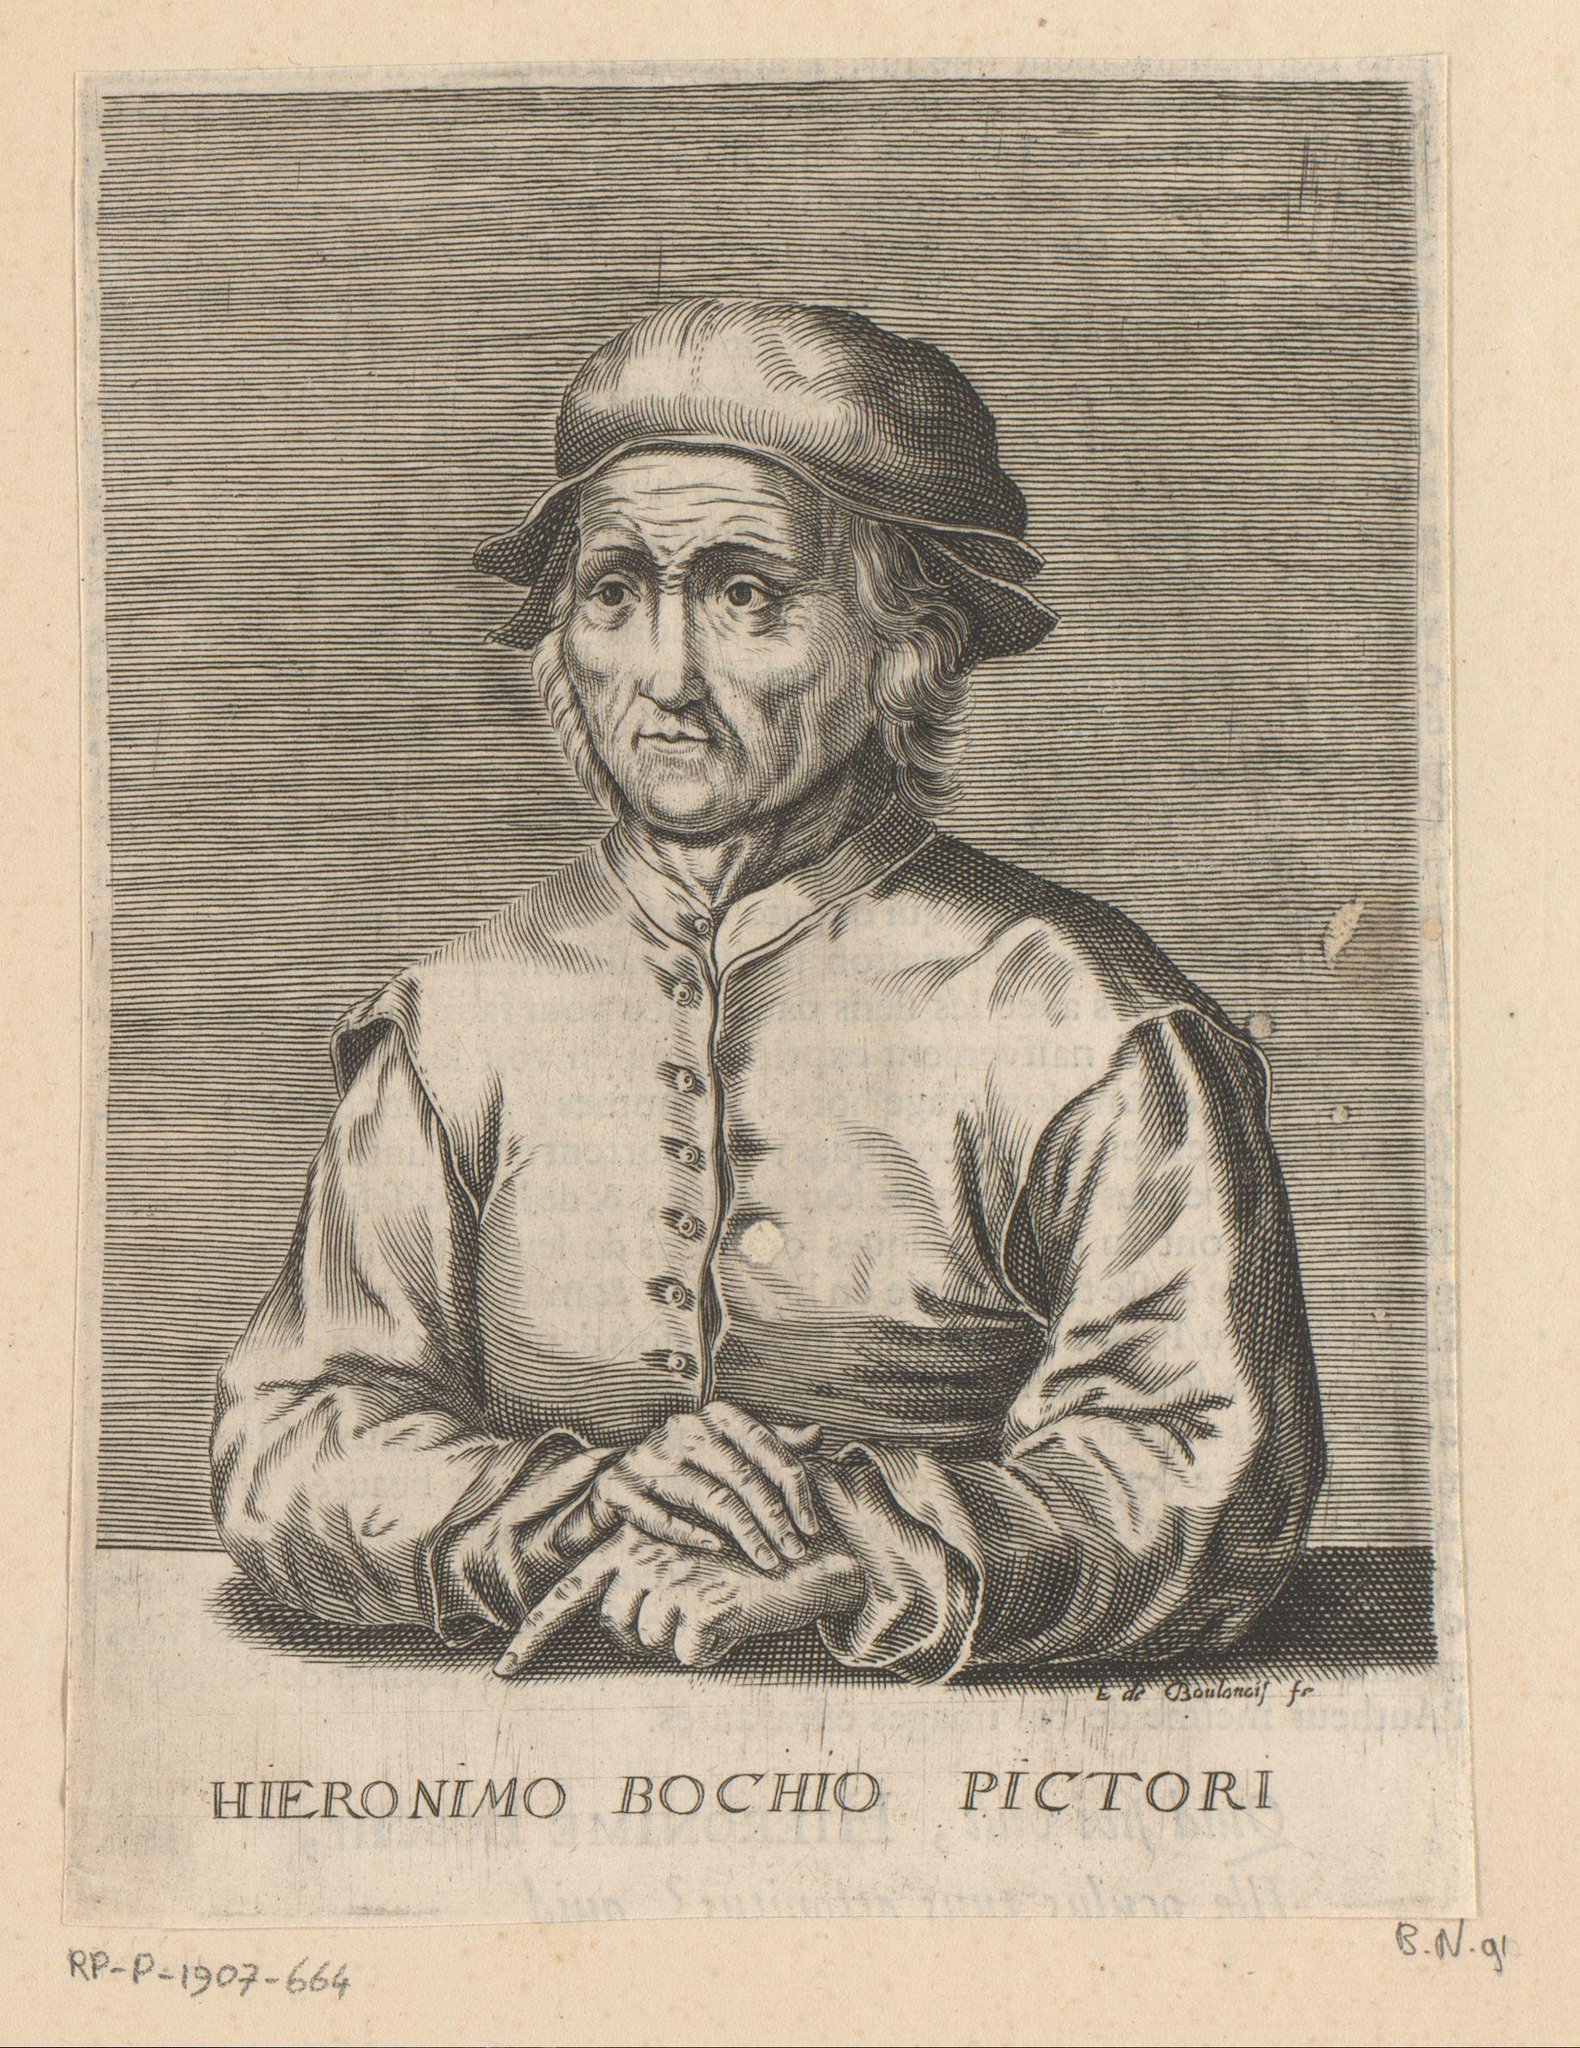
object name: book illustration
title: Portret van Jheronimus Bosch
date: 1682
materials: paper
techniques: engraving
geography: brussels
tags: den bosch, painter, draughtsman, jheronimus bosch, historical persons, portrait, self-portrait of artist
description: Prent uit: Bullert, Isaac. Académie des Sciences et Arts contenant les vies et éloges his. des hommes illustres qui ont excellé en ces professions depuis environ quatre siècles. Brussel: Foppens, François, 1682. Het boek werd in 1682 eveneens in Amsterdam uitgegeven door de erfgenamen van Daniel Elzevier. Deze portretten dienen ter illustratie van de biografie van een kunstenaar of geleerde. De meeste portretten werden door Nicolas de Larmessin vervaardigd (162), 93 door De Boulonois en een derde door ongeïdentificeerde prentmakers. Dit betreft een illustratie op p. 393, deel II.